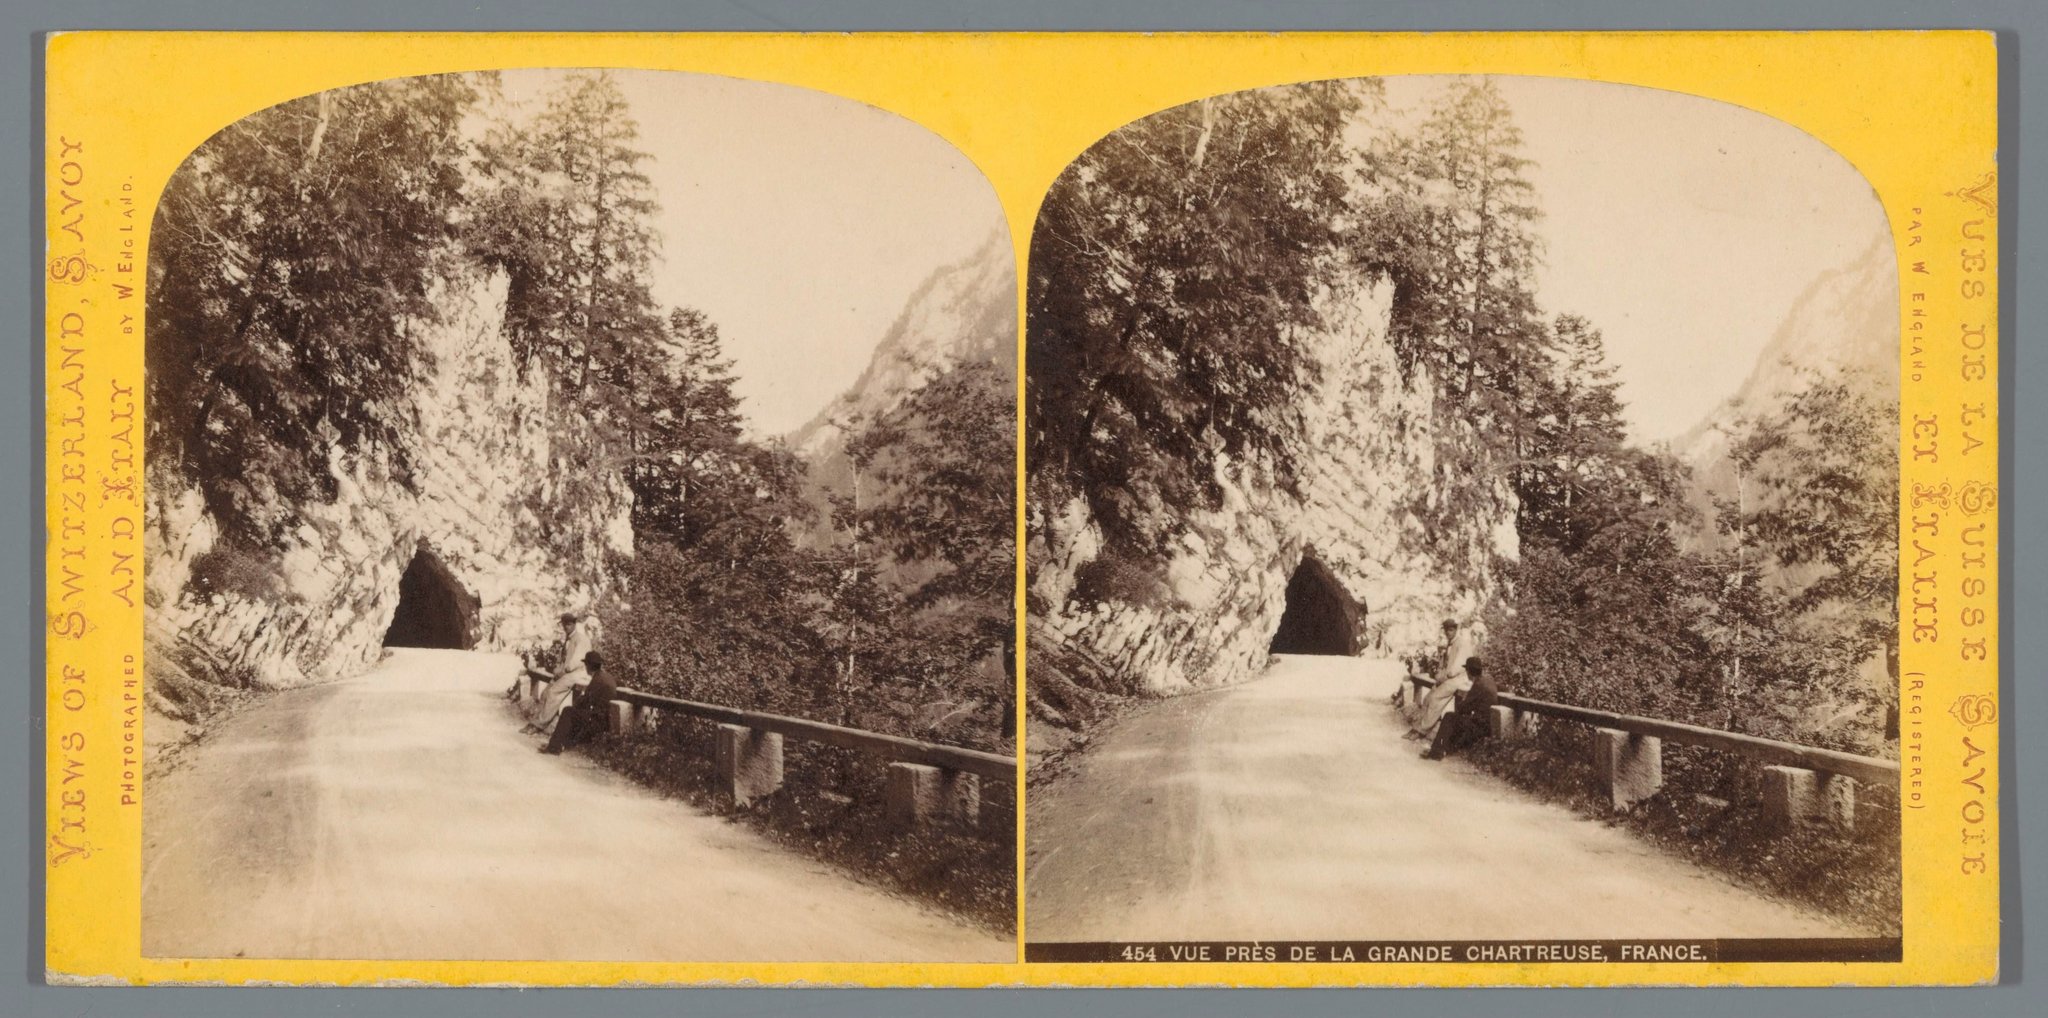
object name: stereograph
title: Gezicht op een tunnel vlakbij het klooster La Grande Chartreuse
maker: william england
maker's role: fotograaf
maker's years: 1816-1896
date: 1850-1880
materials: cardboard, photographic support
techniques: albumen print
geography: grande chartreuse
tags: underground road, tunnel, mountains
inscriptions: number: ‘454’, inscription: ‘Vues de la Suisse Savoie et Italie’